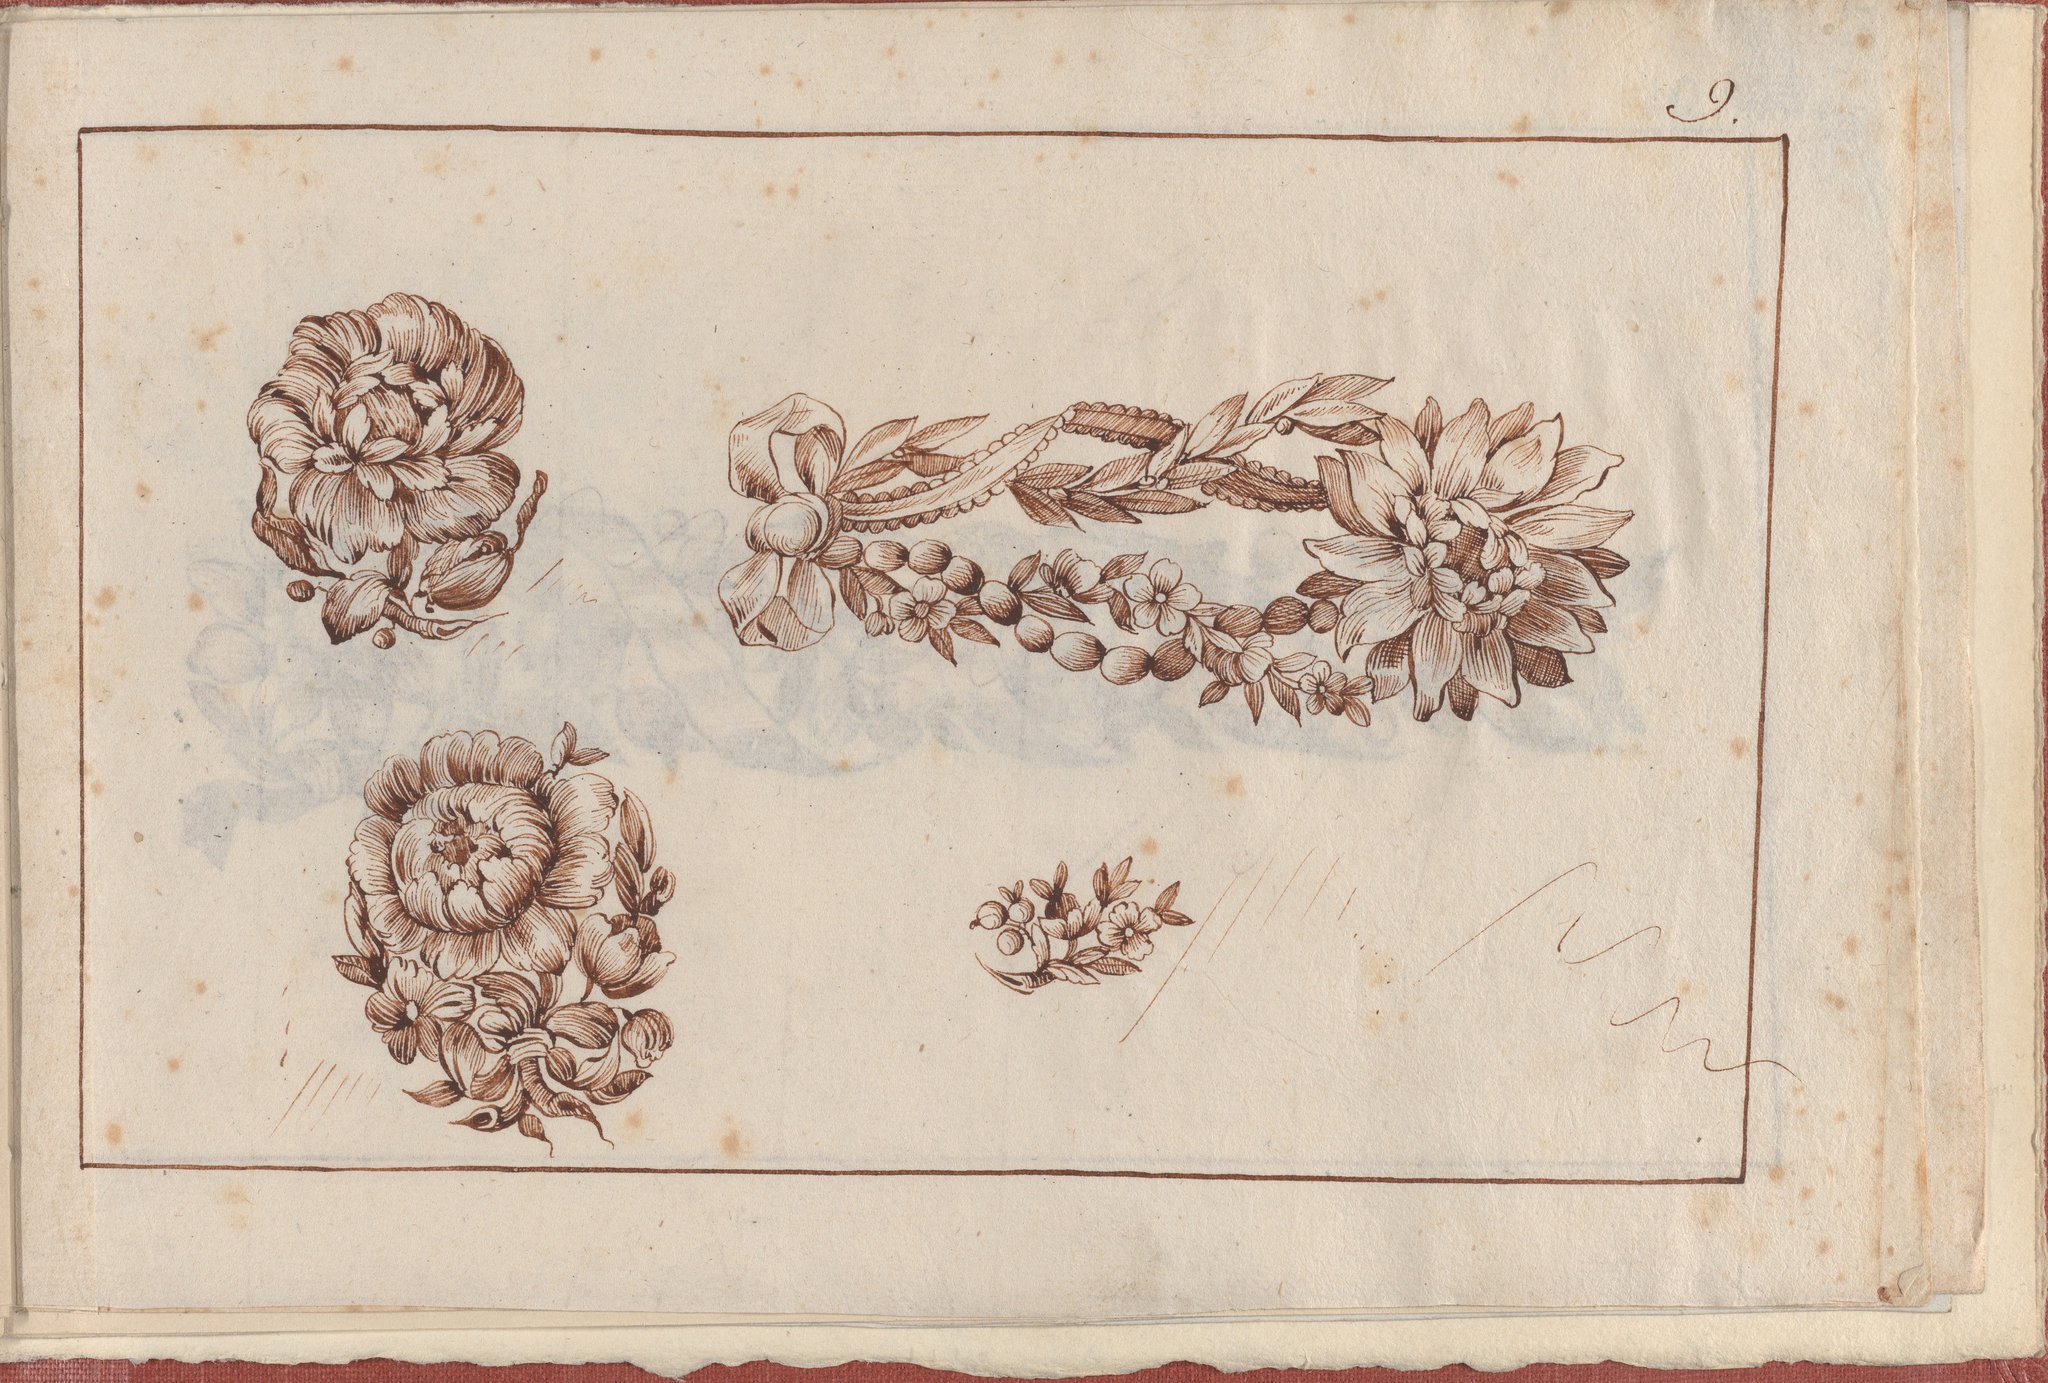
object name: album print ornament architecture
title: Joaillerie: Album of Jewelry Designs, Page 9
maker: anonymous, french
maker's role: artist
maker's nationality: french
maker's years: 1400-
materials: ink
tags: jewelry